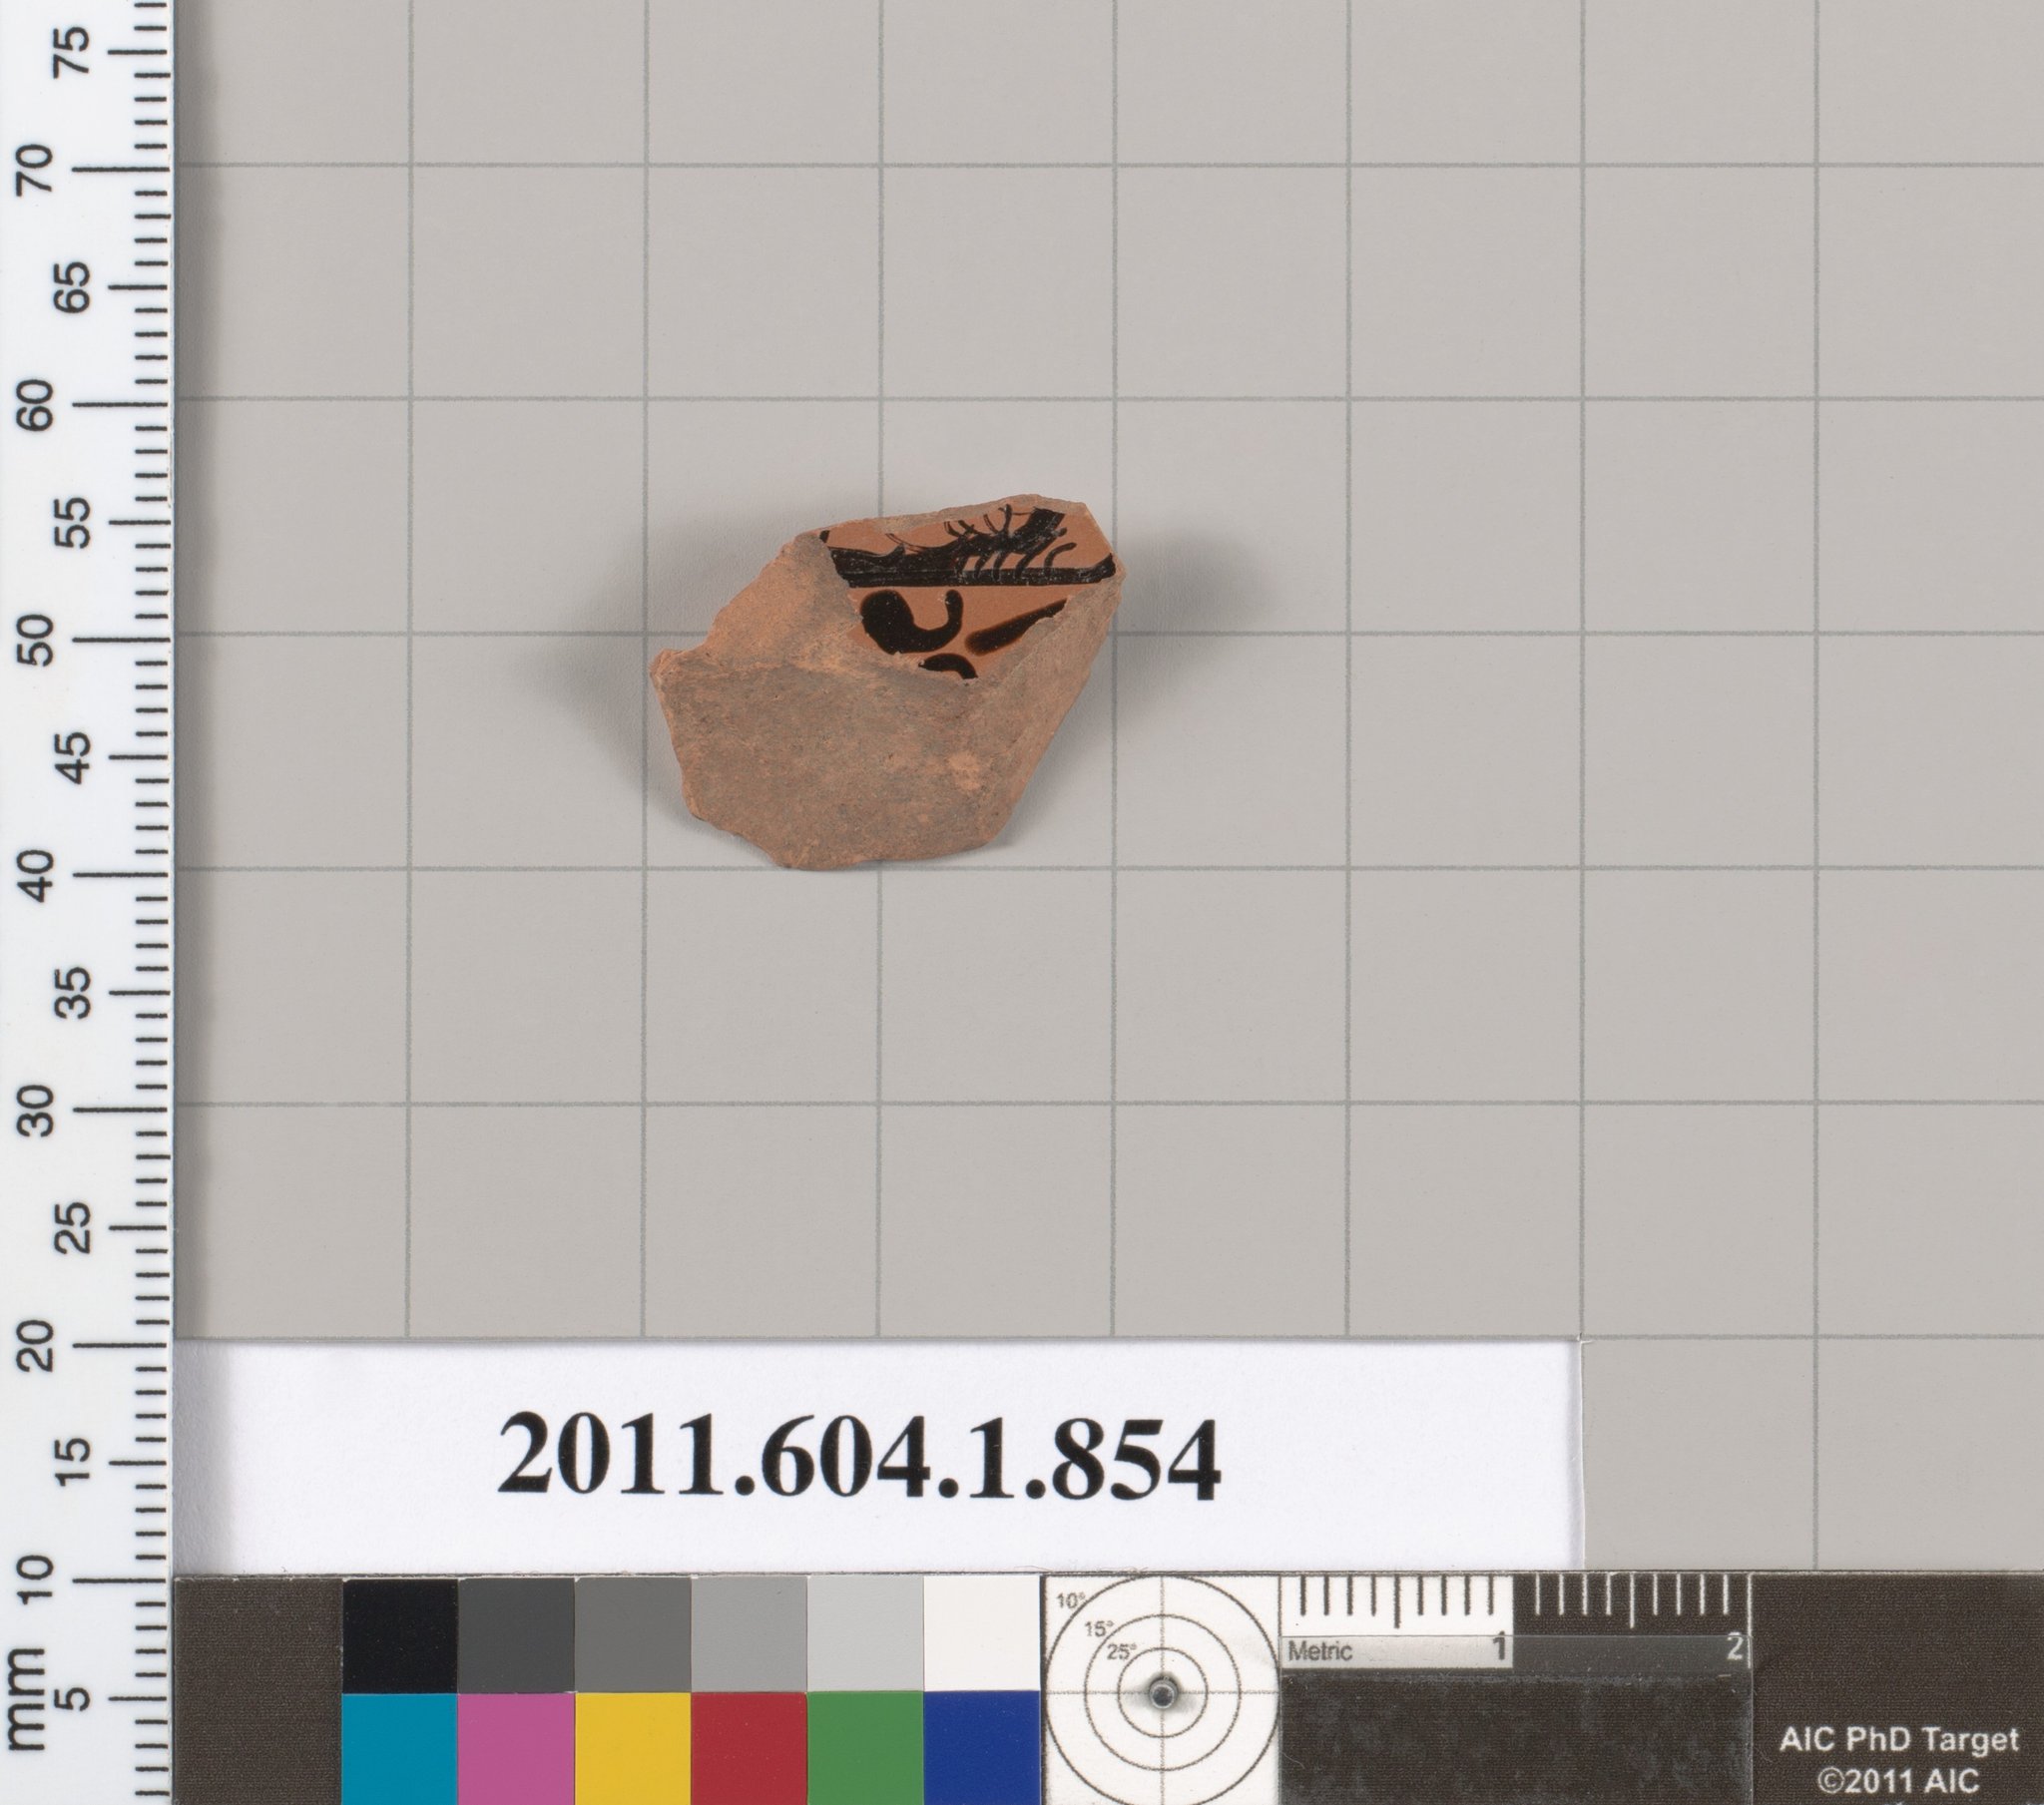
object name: kylix fragment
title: Terracotta fragment of a kylix (drinking cup)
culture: greek, attic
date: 500-480 BCE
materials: terracotta